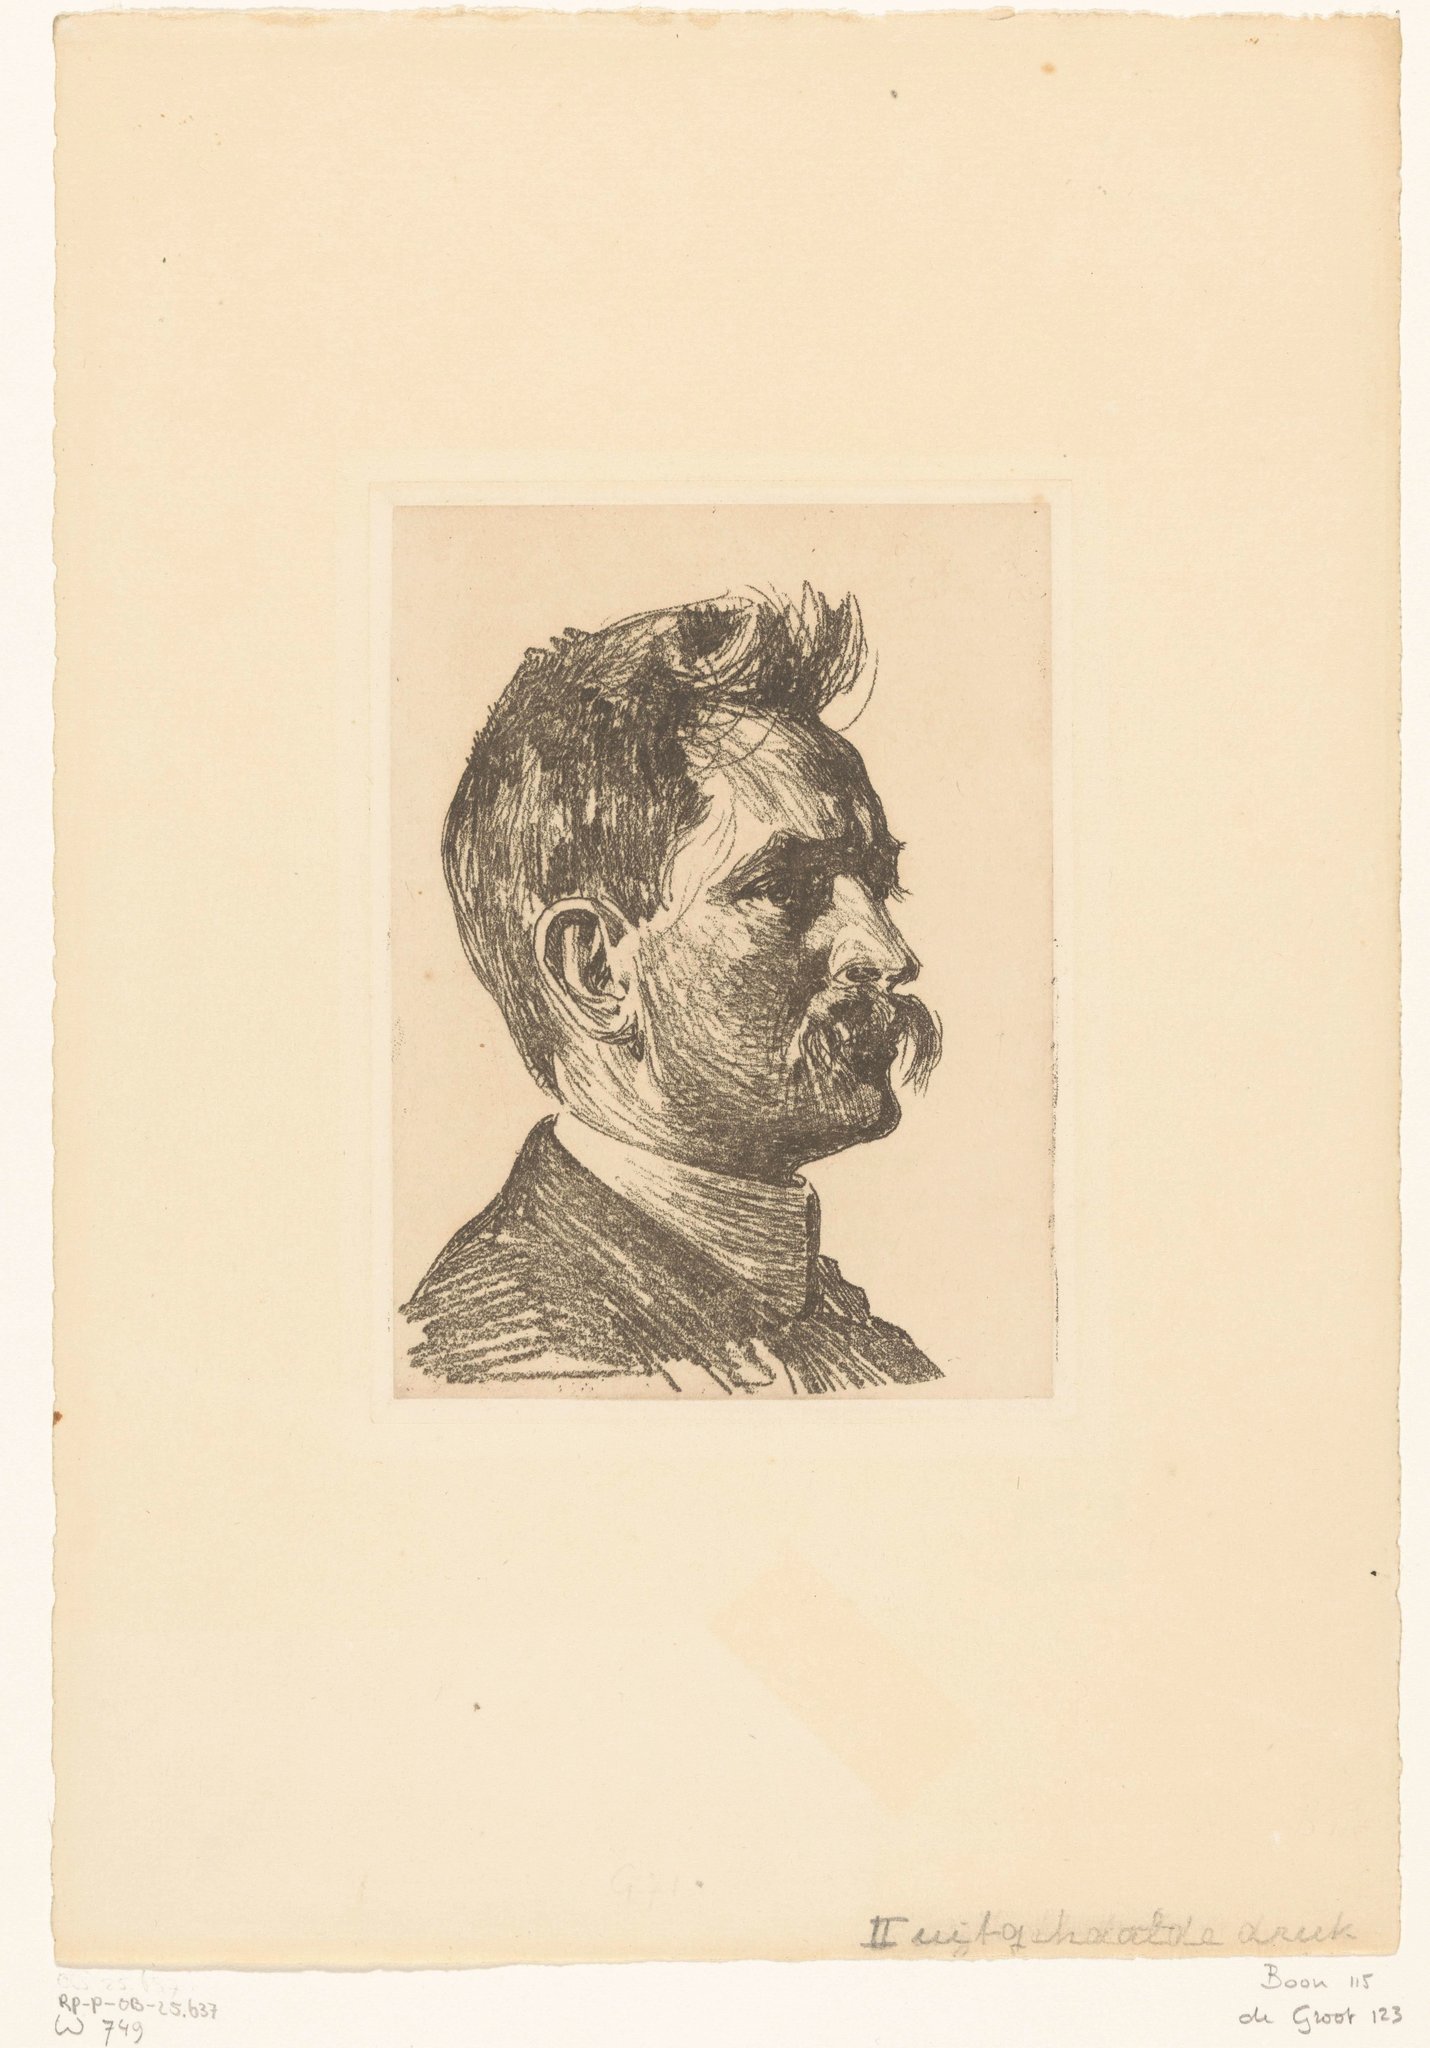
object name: print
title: Portret van Jan Hofker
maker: willem witsen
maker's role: draughtsman, painter, print maker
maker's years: 1860-1923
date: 1905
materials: paper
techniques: soft ground etching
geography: amsterdam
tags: portrait of a writer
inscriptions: watermark, inscription: ‘II uitgehaalde druk’